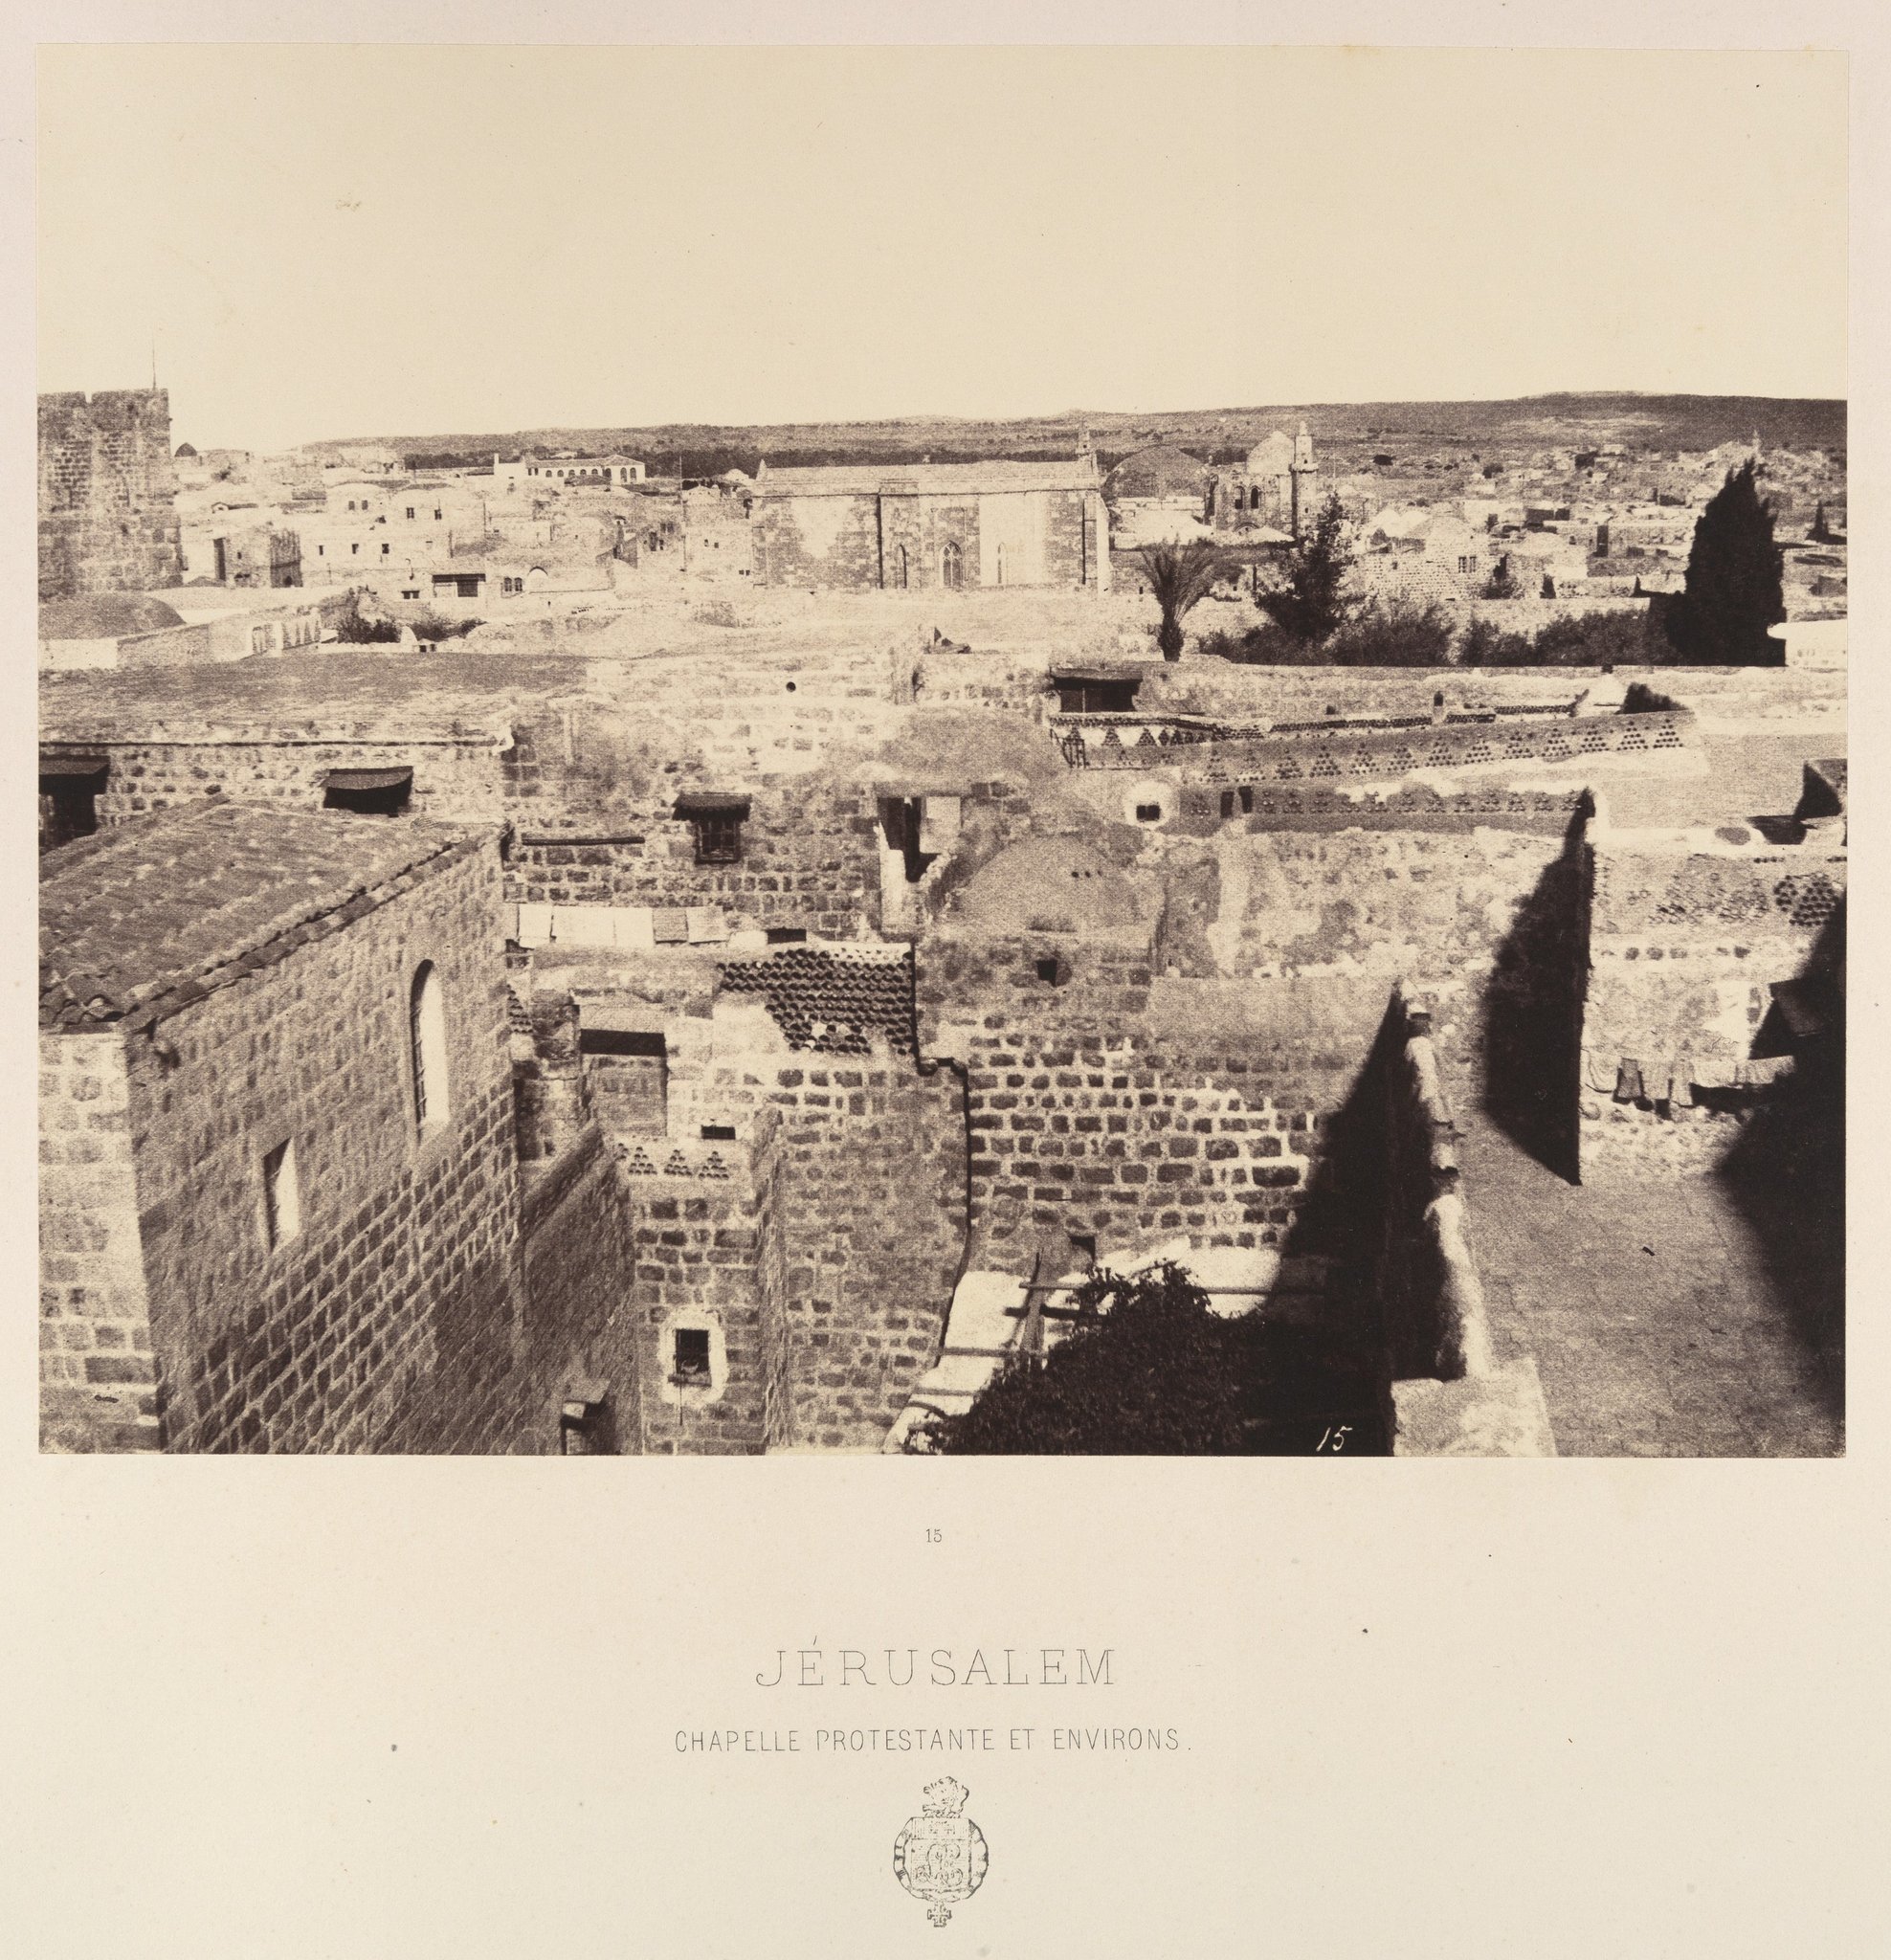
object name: photograph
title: Jérusalem. Chapelle protestante et environs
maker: louis de clercq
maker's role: artist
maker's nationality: french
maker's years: 1837-1901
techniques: albumen silver print, paper negative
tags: architecture,cities